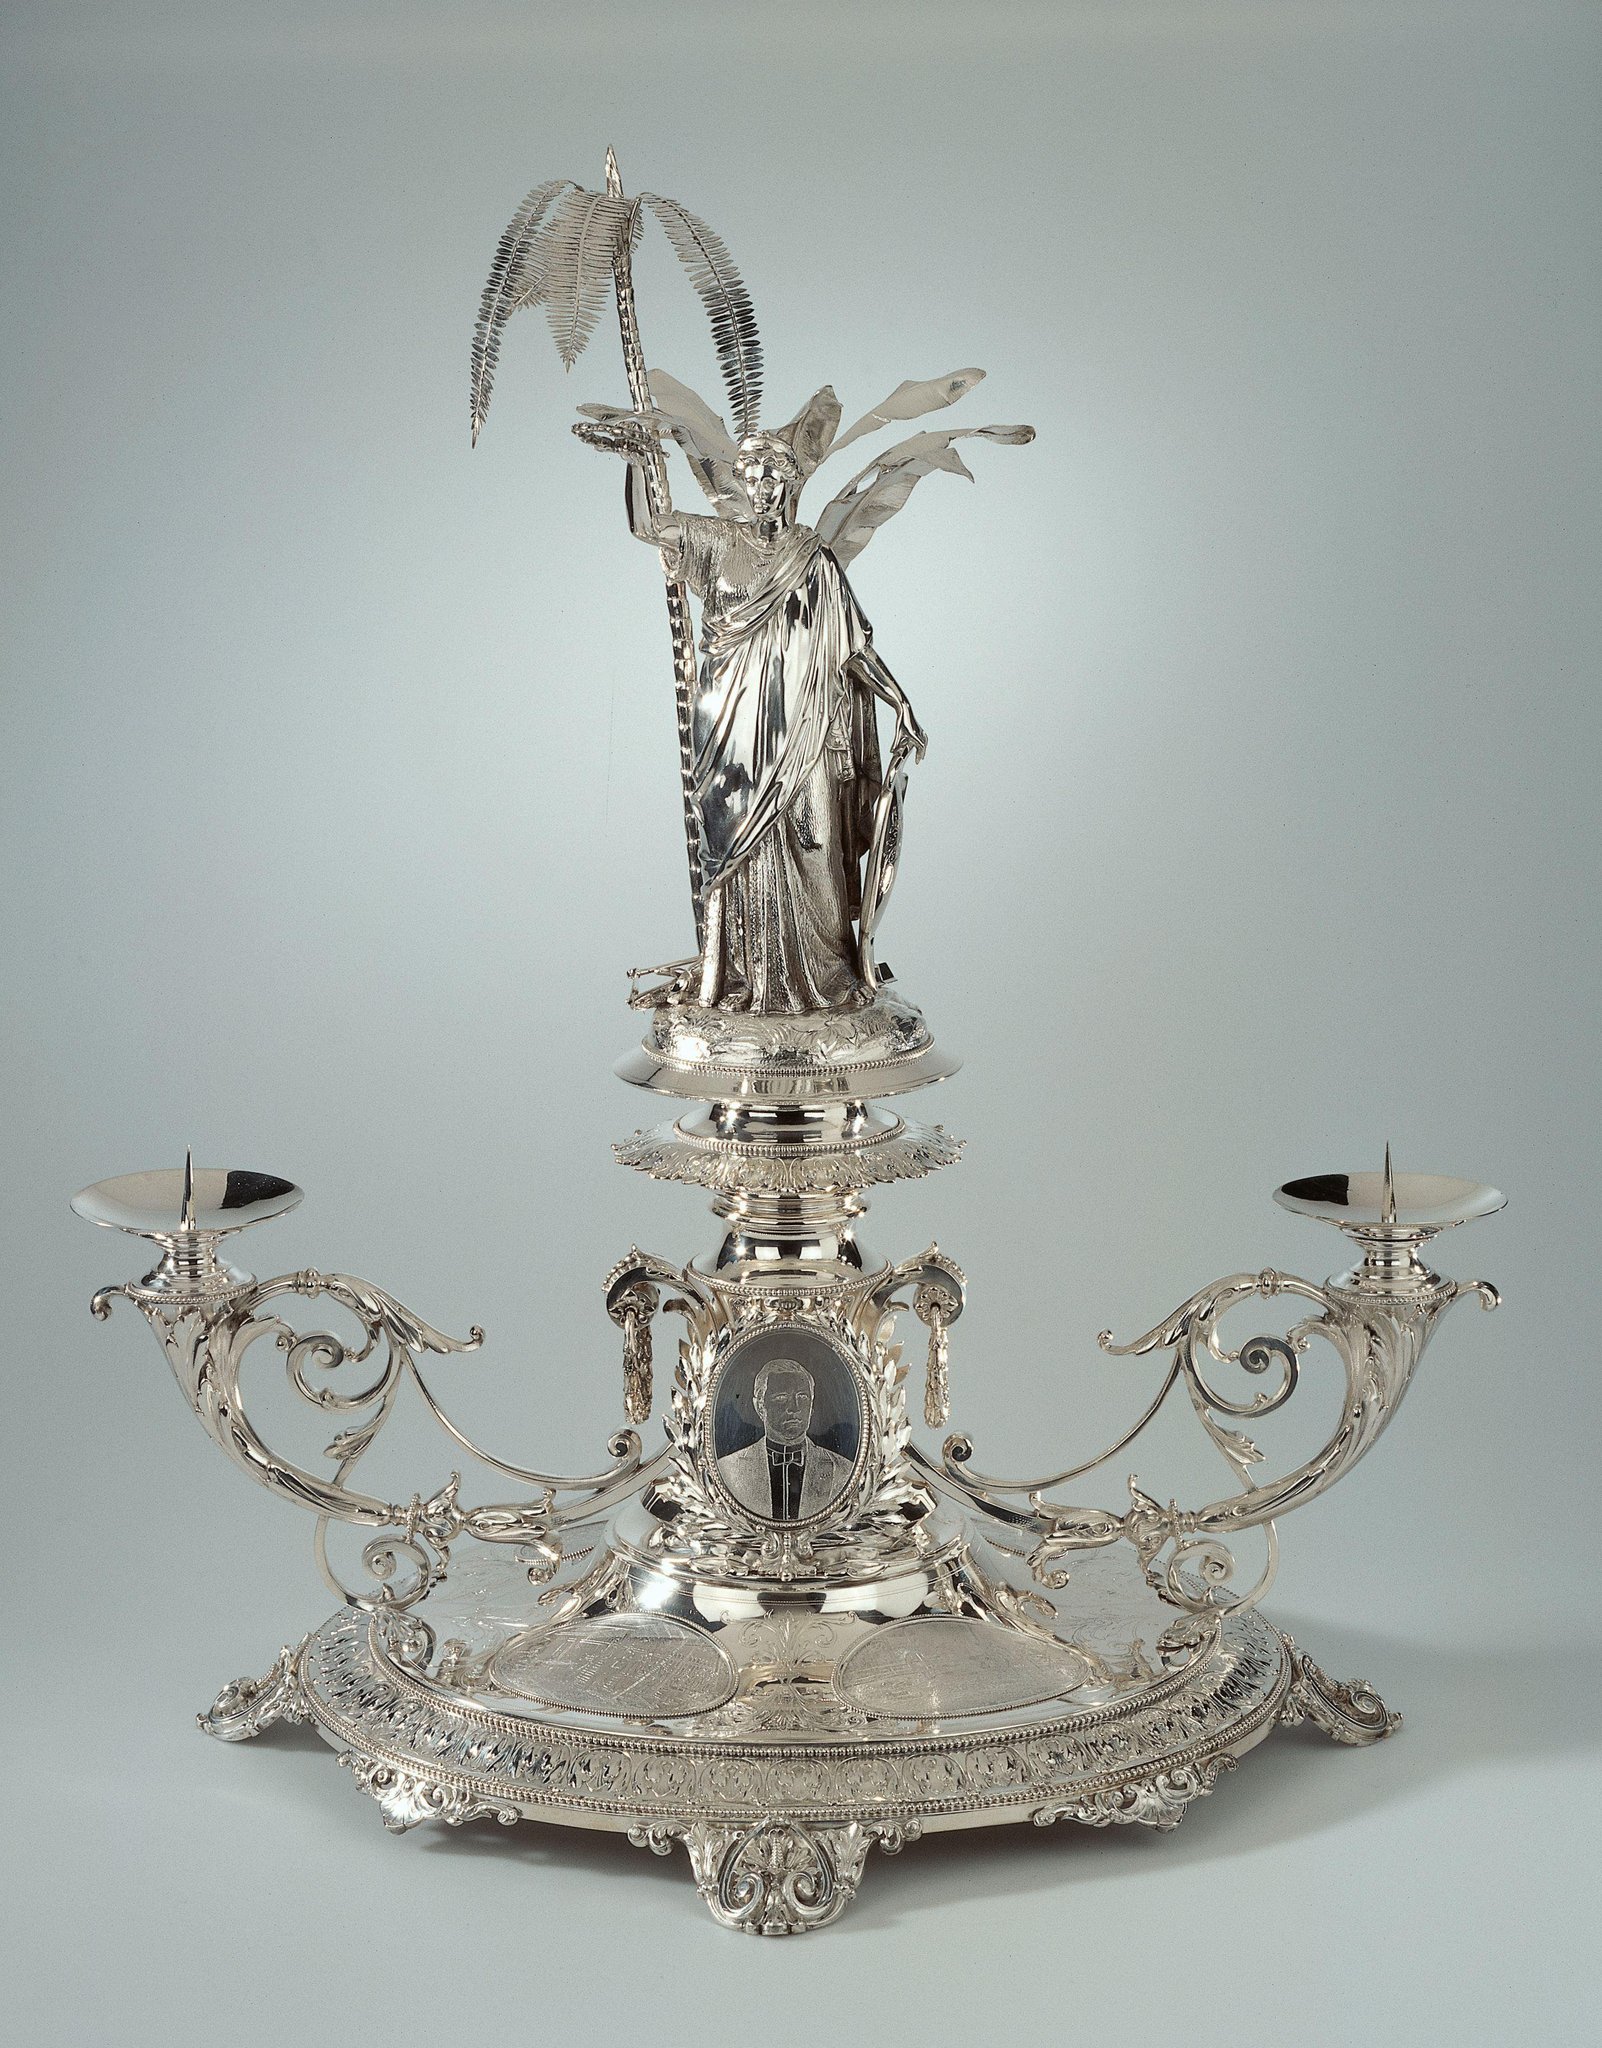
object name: table piece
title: Pièce de milieu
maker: johannes mattheus van kempen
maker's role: silversmith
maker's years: 1814-1877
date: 1900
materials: silver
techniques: engraving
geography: voorschoten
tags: dutch east indies, the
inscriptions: date letter: ‘q’, mark, inscription: ‘Beambten en mijnwerkers der Billiton maatschappij aan hunnen hooggeachte chef J.Ph. Ermeling ter gelegenheid van zijn 70ste verjaardag 21 januari 1901.’, mark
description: Palmtakken van het bovenstuk van het tafelstuk voorstellende een vrouw met o.a. schild en lauwerkrans (Sri-Billiton) en attributen ontleend aan het werk in de tinmijnen. Rondom het voetstuk 4 medaillons met voorstellingen van de arbeid in de tinmijnen (naar foto's). Op het voetstuk een medaillon met tekst en één met het gegraveerde portret van Ermeling. Bovenaan achter de vrouw twee palmen; aan beide zijden van het voetstuk een kaarsenarm. Tafelstuk is aangeboden door beambten en mijnwerkers van de Billiton Maatschappij aan hun chef J.Ph. Ermeling bij zijn 70ste verjaardag op een feest op Billiton.